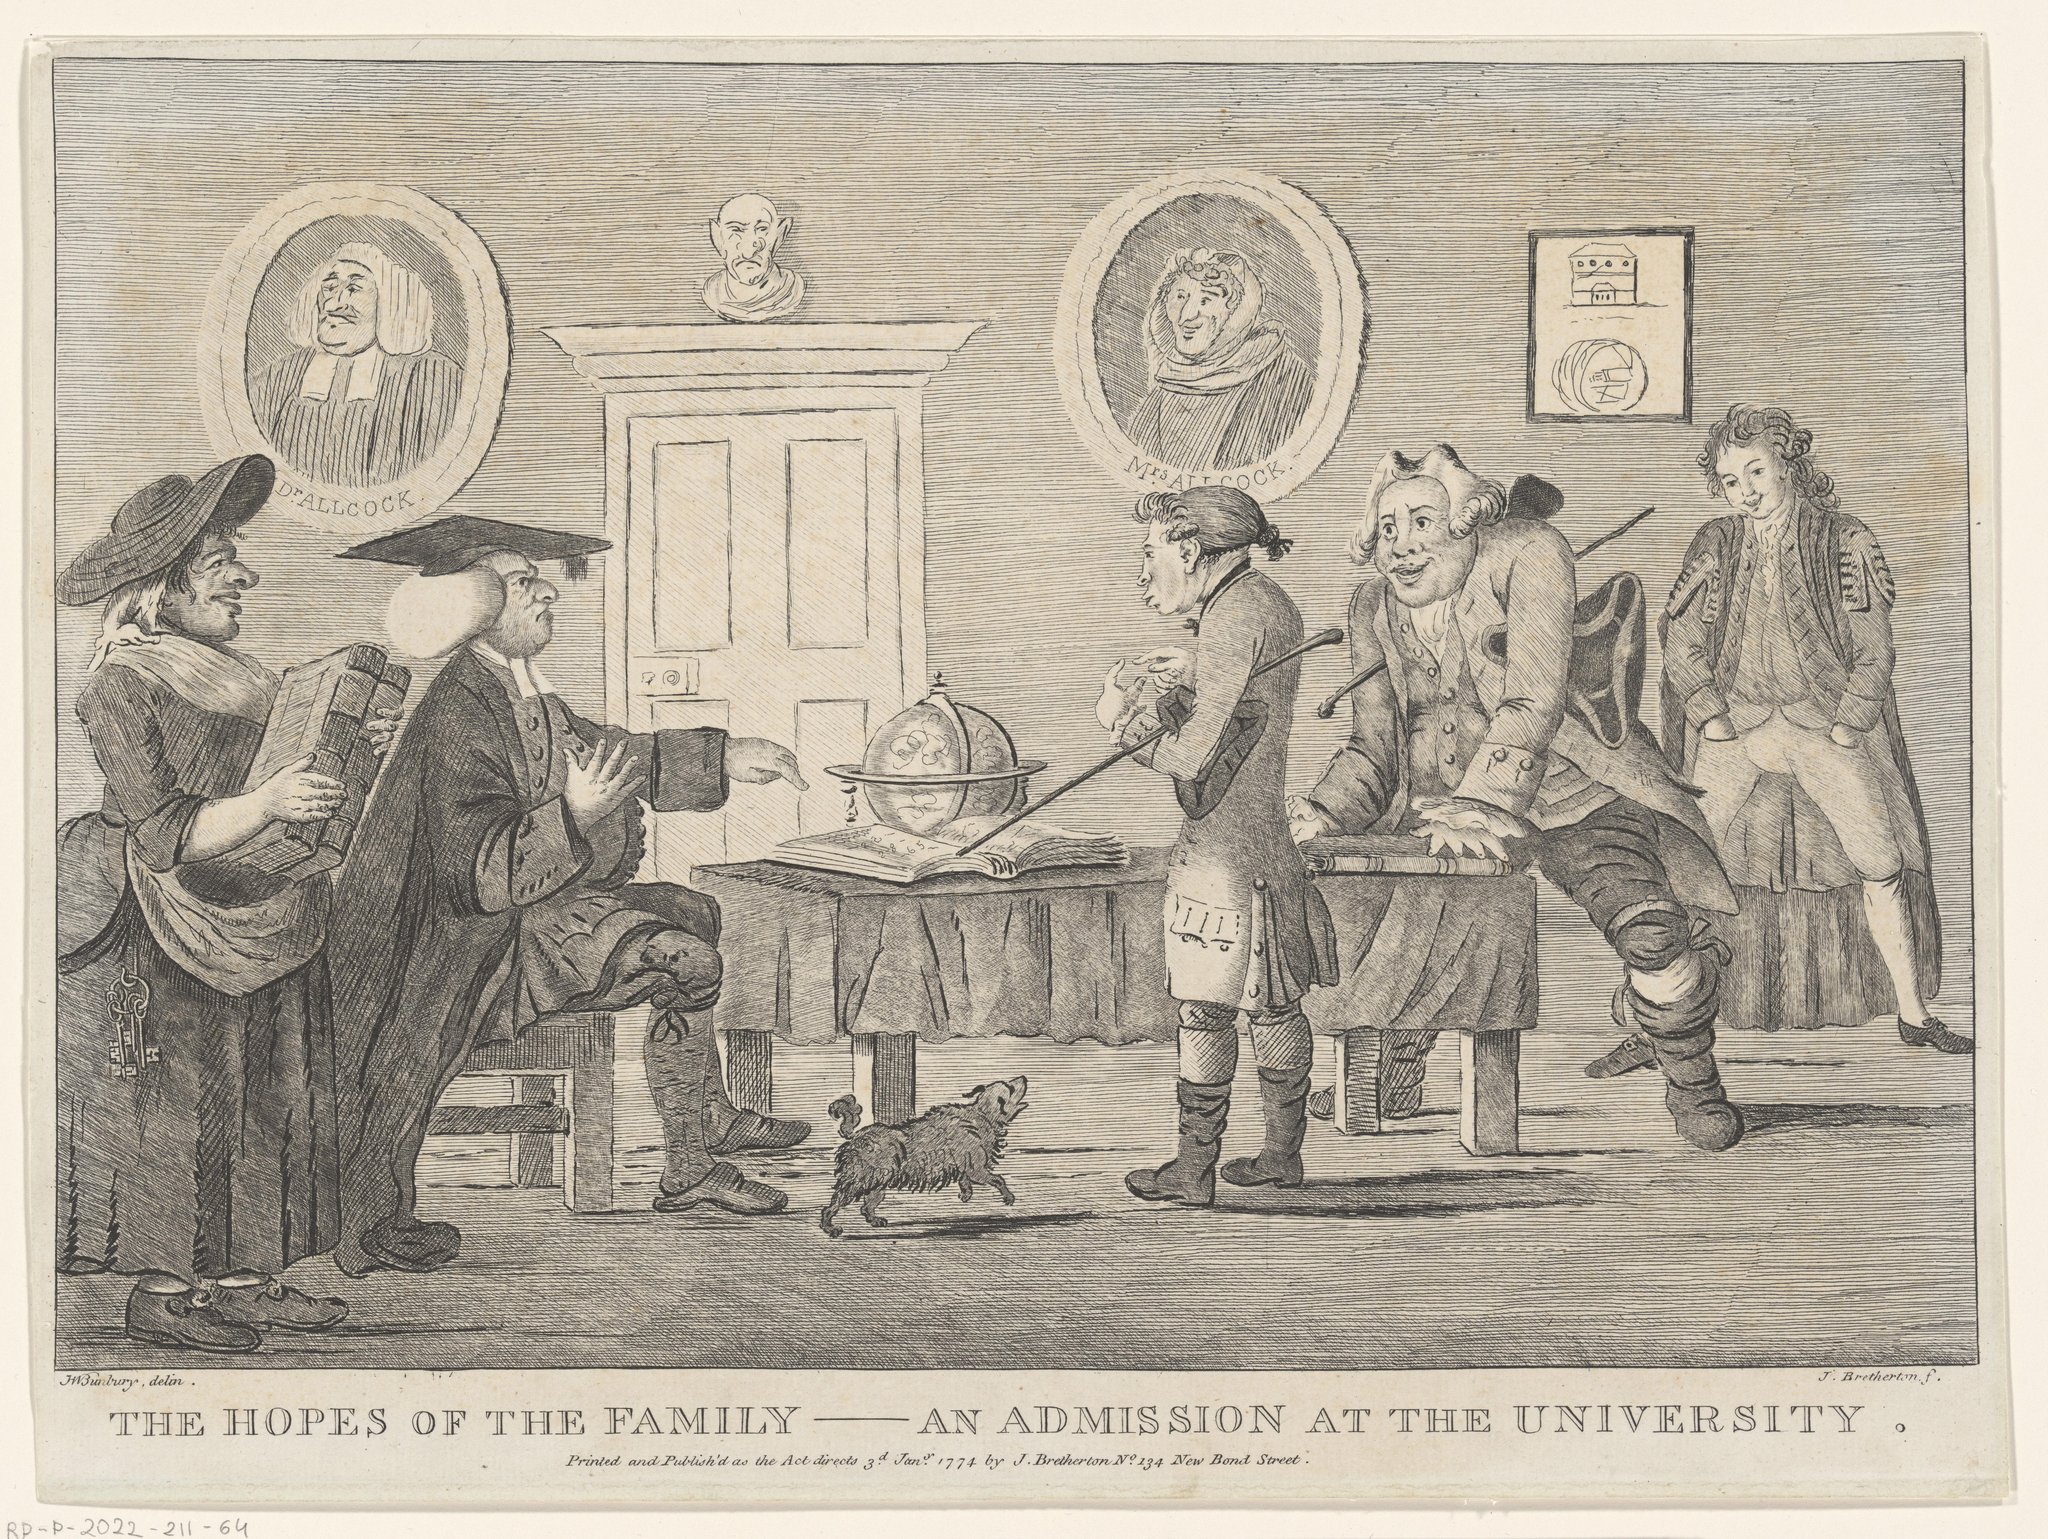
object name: cartoon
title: De hoop van de familie - een toelating aan de universiteit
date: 1774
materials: paper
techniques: etching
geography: london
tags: caricatures (human types), examination ~ university, professor, student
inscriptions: collector's mark: Lugt 2228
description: Satire op een sociaal ambitieuze familie. Een jongeman wordt door een docent geëxamineerd voor toelating tot de universiteit van Cambridge. De docent, in academische gewaden, zit aan een tafel en wijst naar een groot wiskundig boek dat naast een wereldbol rust. De jongeman staat op zijn vingers te tellen terwijl zijn gretige vader hem aanspoort.